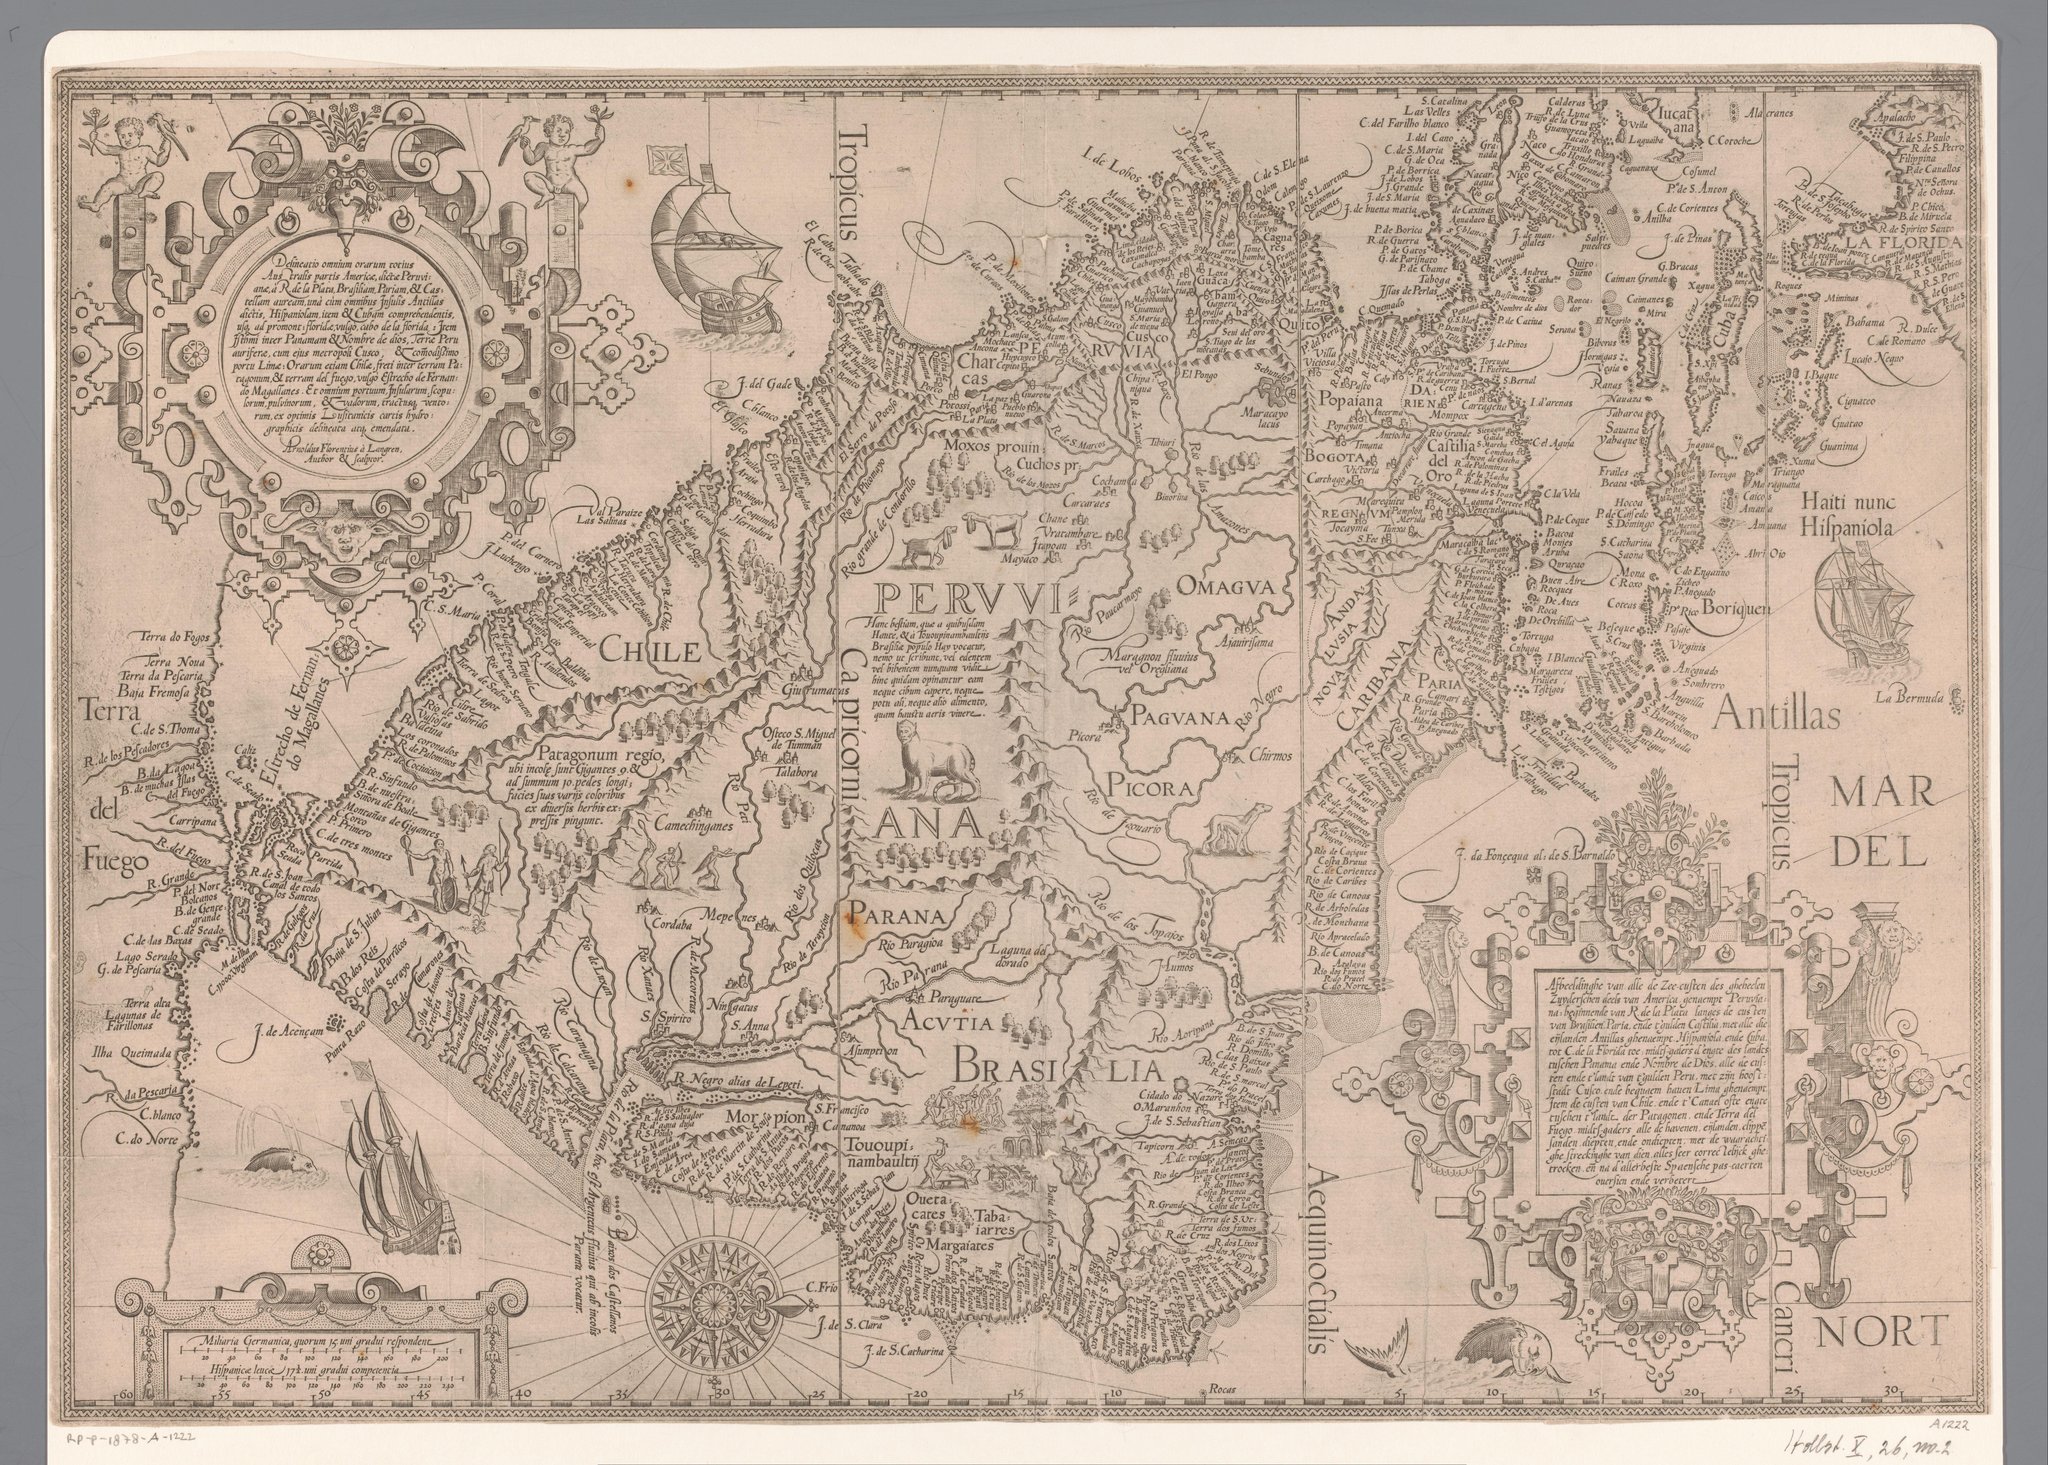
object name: print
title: Kaart van Zuid-Amerika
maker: arnold floris van langren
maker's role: print maker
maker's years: 1571-1644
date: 1581-1644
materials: paper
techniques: etching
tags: maps, atlases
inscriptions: collector's mark: Lugt 2228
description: Kaart van Zuid-Amerika. Linksboven een cartouche met titel in het Latijn. Rechtsonder een cartouche met titel in het Nederlands.